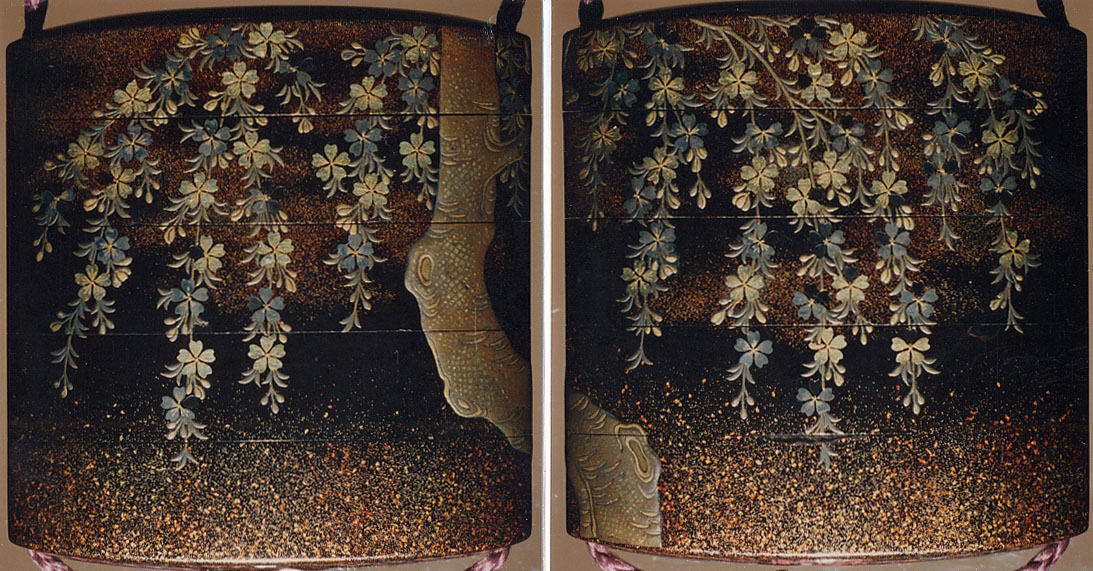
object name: inrō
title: Case (Inrō) with Design of Weeping Cherry Tree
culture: japanese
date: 1801-1900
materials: gold, gold foil, lacquer, silver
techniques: fundame, hiramakie, roiro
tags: flowers,trees